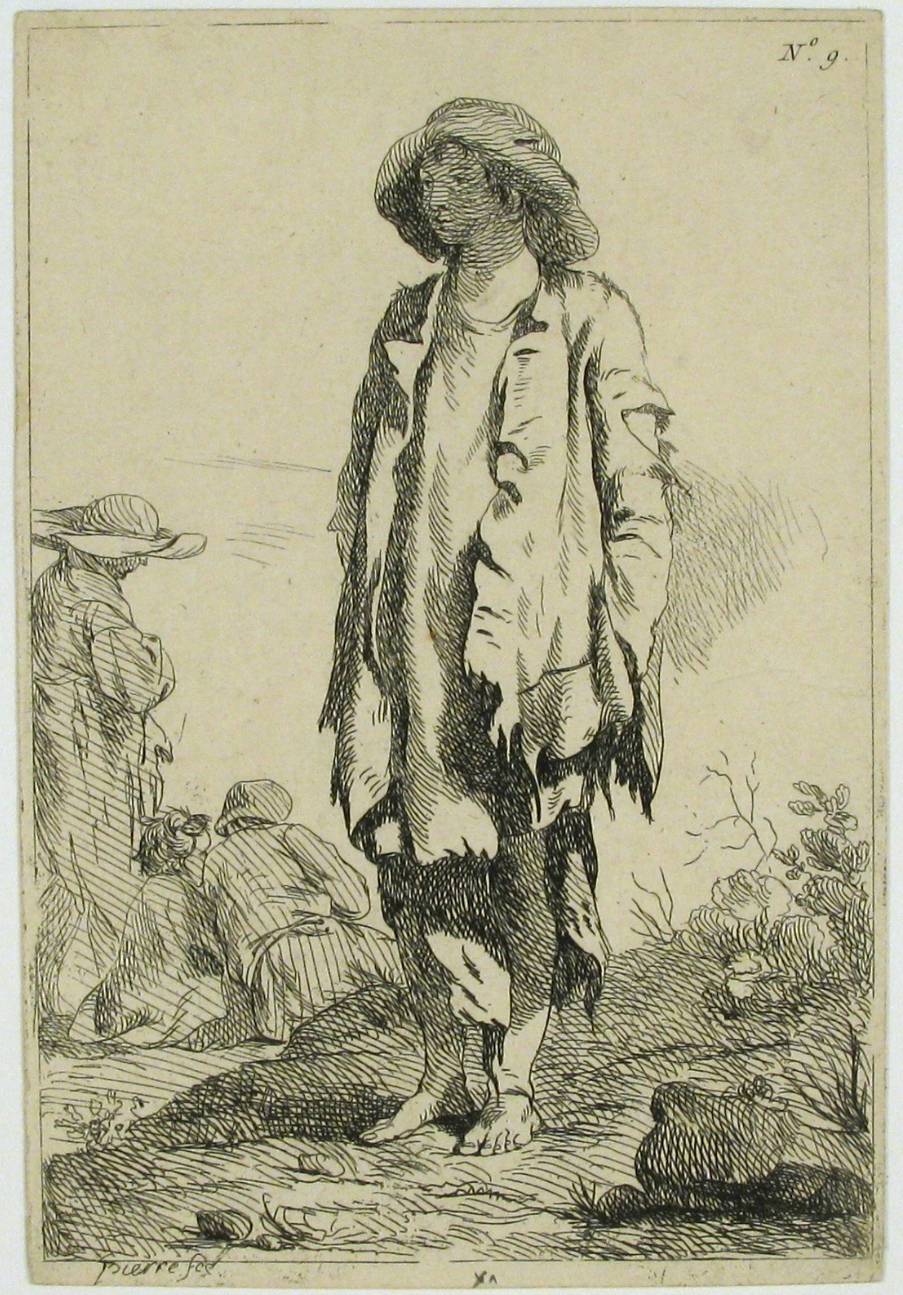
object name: print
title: Beggar Family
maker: jean-baptiste marie pierre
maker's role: artist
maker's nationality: french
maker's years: 1714-1789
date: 1735-1737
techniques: etching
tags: men,family